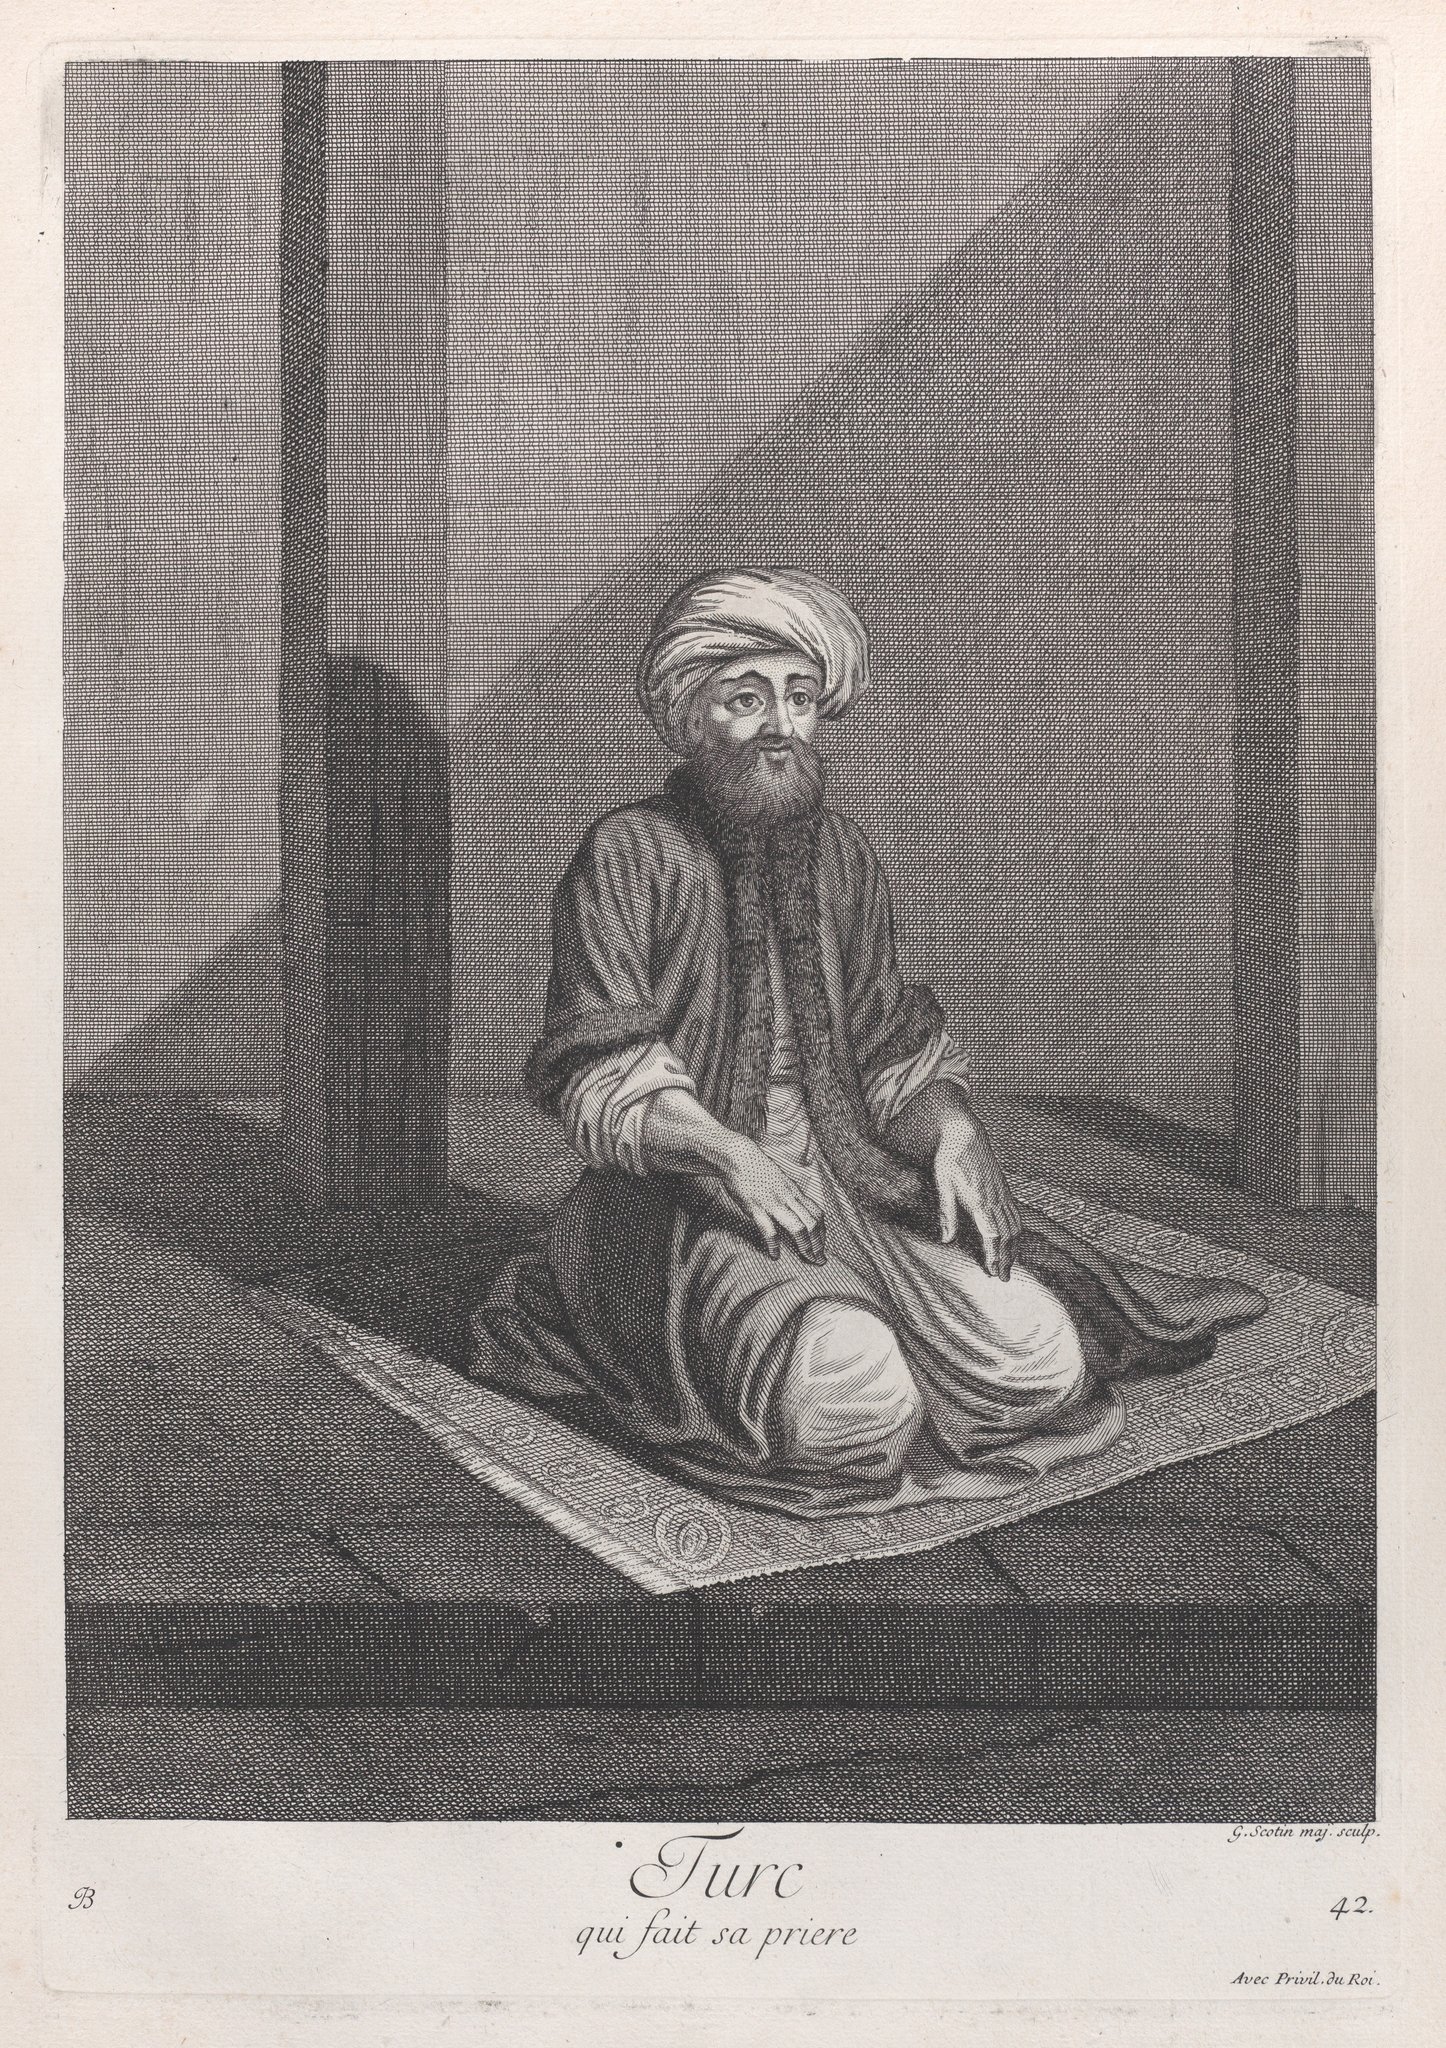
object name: print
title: Turc, qui fait sa priere, plate 42 from "Recueil de cent estampes représentent differentes nations du Levant"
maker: jean baptiste vanmour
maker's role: artist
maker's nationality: french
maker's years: 1671-1737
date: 1714-1715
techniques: engraving, etching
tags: men